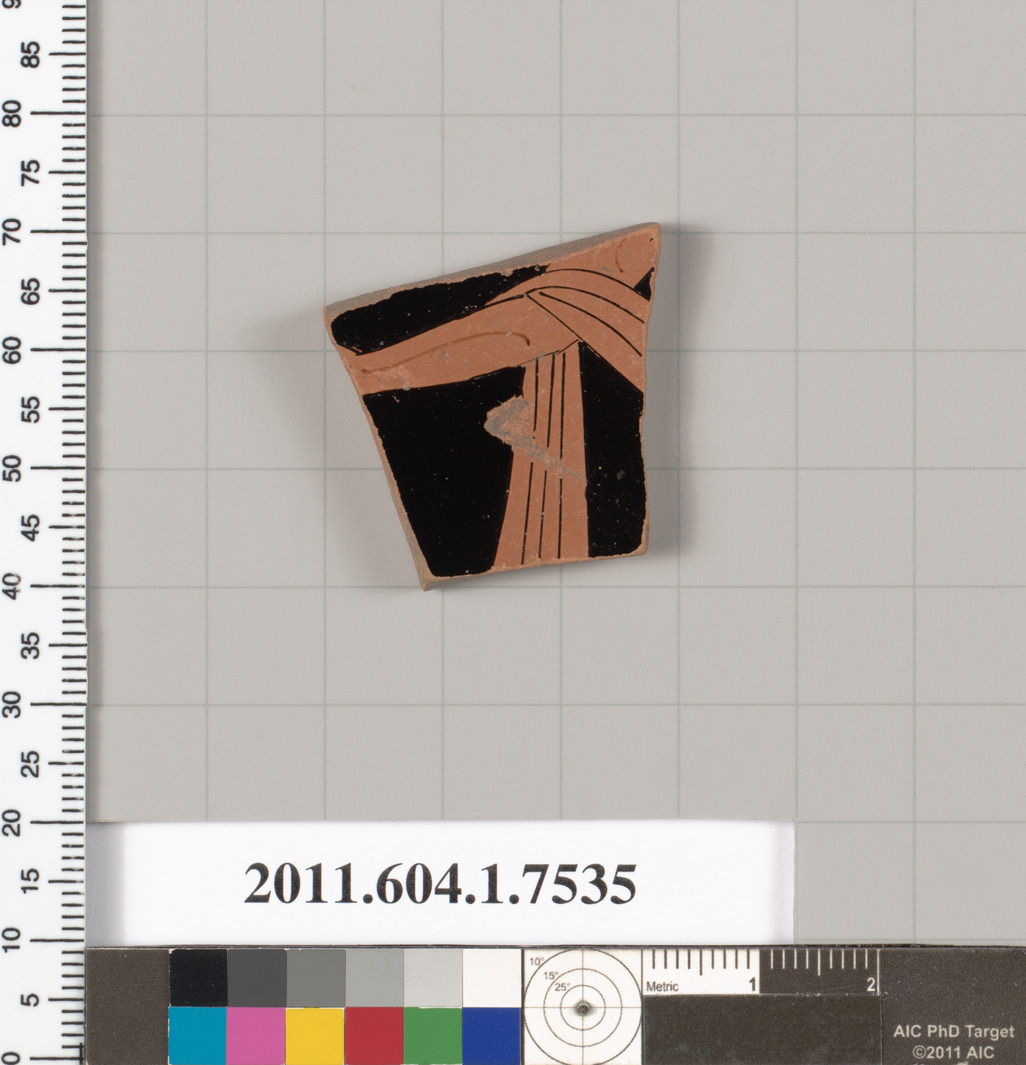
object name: kylix fragment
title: Terracotta fragment of a kylix (drinking cup)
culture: greek, attic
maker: euaion painter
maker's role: artist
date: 460-450 BCE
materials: terracotta